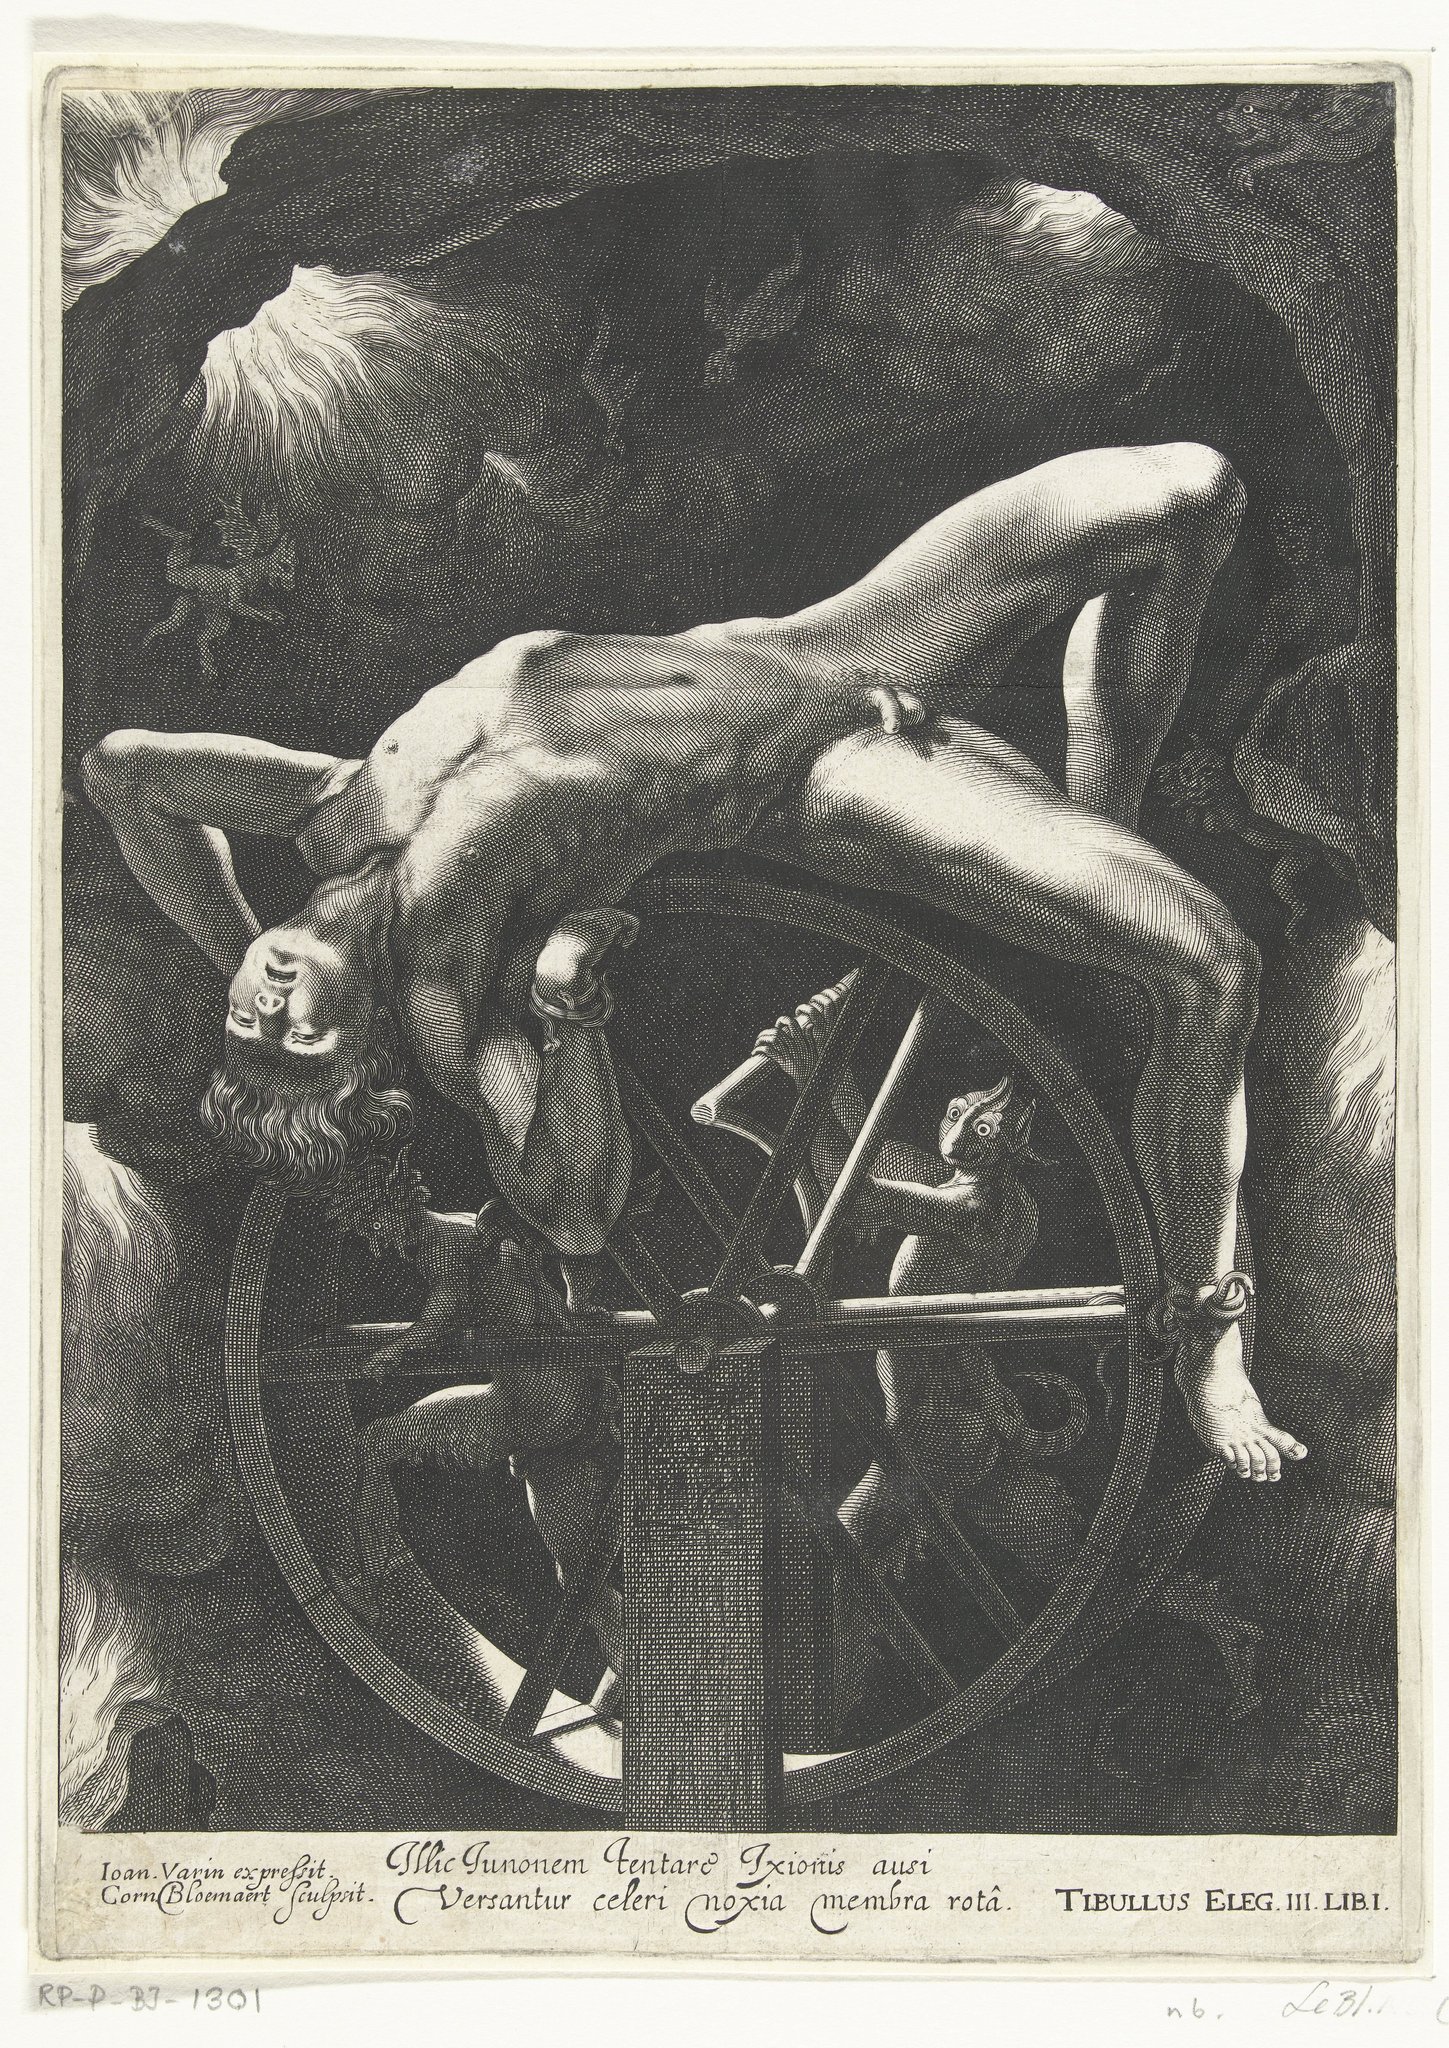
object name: book illustration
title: Ixion op het rad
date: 1655-1700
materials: paper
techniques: engraving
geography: paris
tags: ixion on a burning wheel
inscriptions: collector's mark: Lugt 2228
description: Ixion heeft zijn schoonvader vermoord en ondergaat zijn straf in de Hades. Voor straf werd hij op een vurig, altijd brandend wiel gebonden. Het wiel wordt draaiende gehouden door centauren. Met een vers in het Latijn.